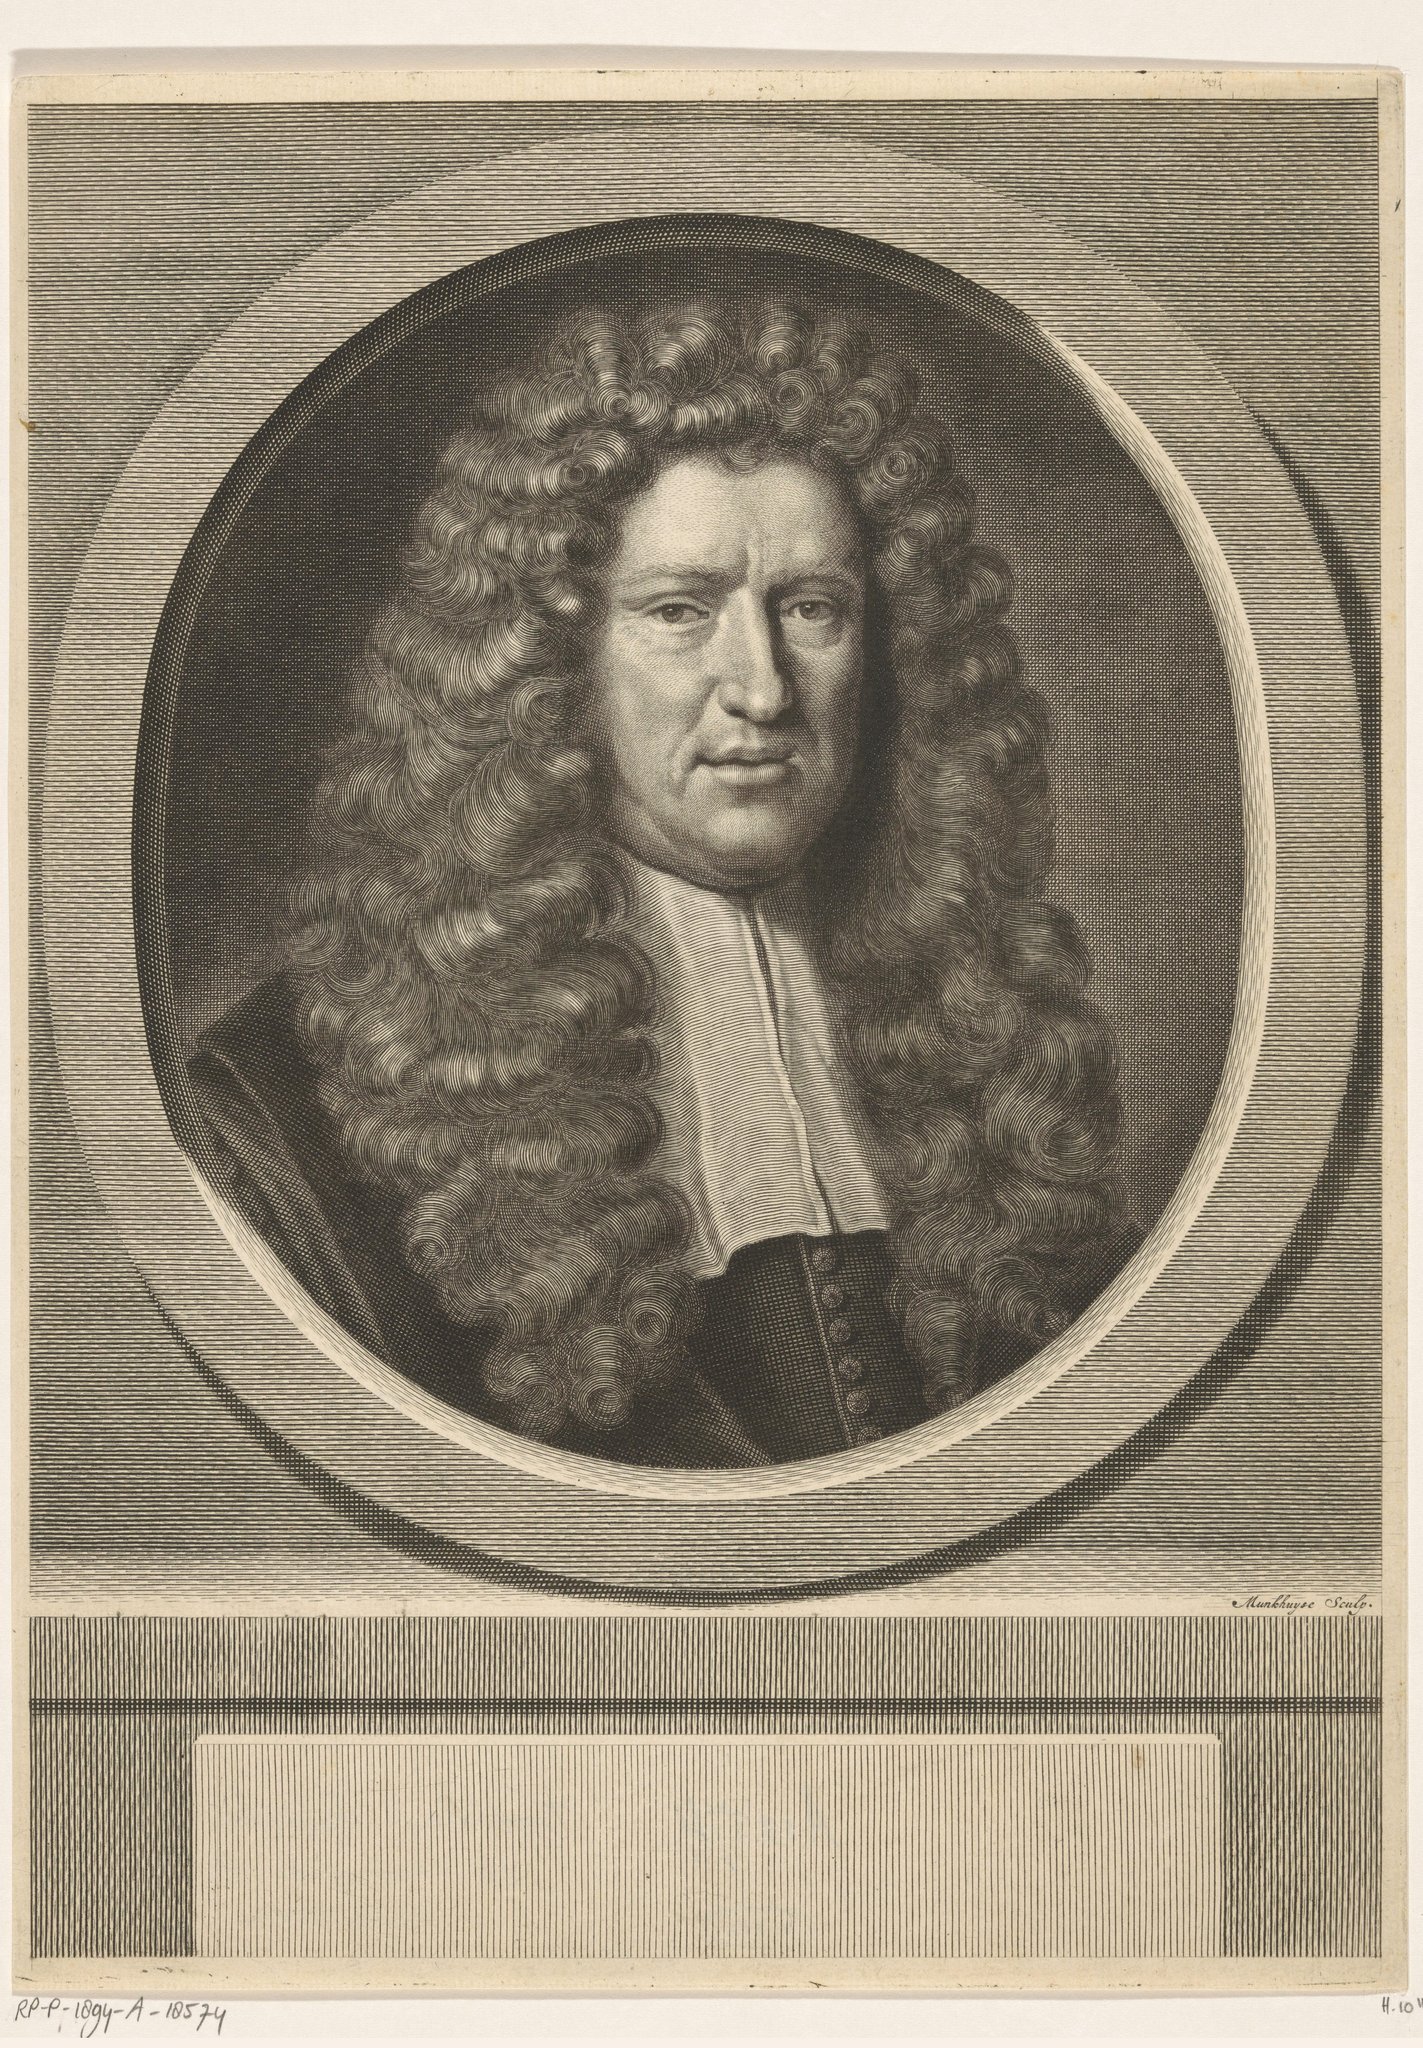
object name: print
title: Portret van Karel Rudolph van Kuffeler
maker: jan van munnickhuysen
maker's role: draughtsman, print maker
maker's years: 1655-1701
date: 1685-1702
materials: paper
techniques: engraving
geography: netherlands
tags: amsterdam, politician, historical persons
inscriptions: collector's mark: Lugt 2228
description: Portret van Karel Rudolph van Kuffeler met witte bef.